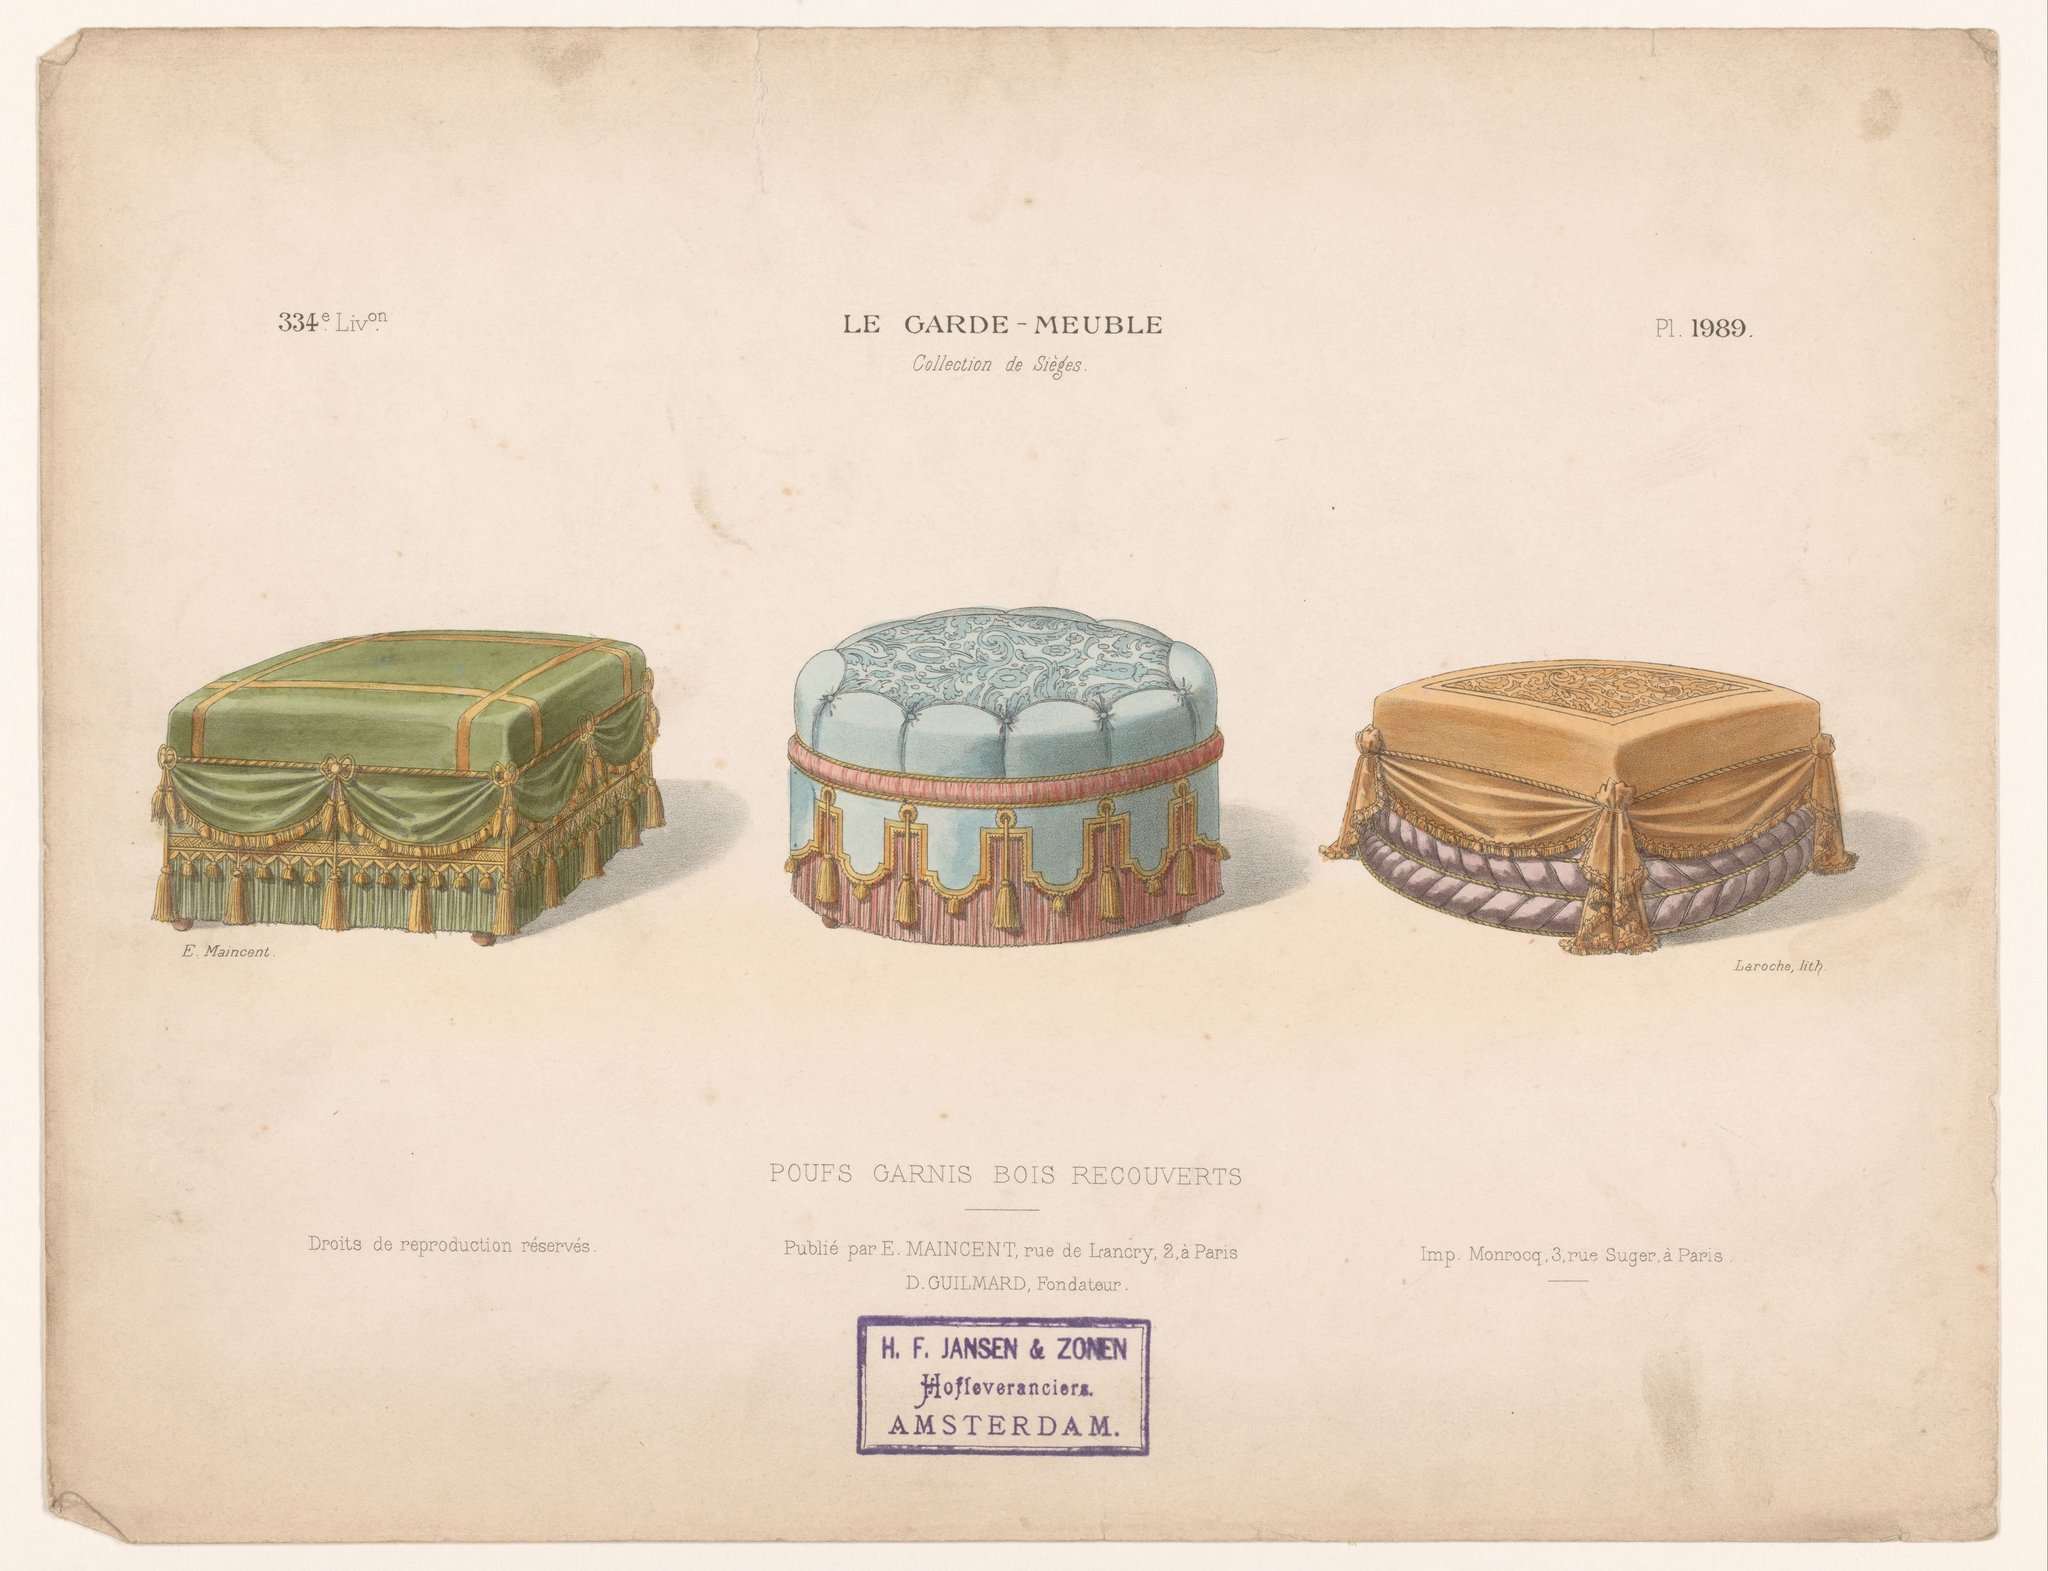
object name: print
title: Le garde-meuble / Collection de Sièges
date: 1885-1895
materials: paper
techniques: hand coloring, lithograph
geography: paris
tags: seating furniture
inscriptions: stamp: ‘H.F. Jansen & Zonen Hofleveranciers Amsterdam’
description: Ieder Livraison in de serie Le Garde-Meuble bevat negen platen: drie 'sièges' (zitmeubels), drie 'meubles' (diverse meubels zoals tafels en kasten) en drie 'tentures' (gordijnen en draperieën).